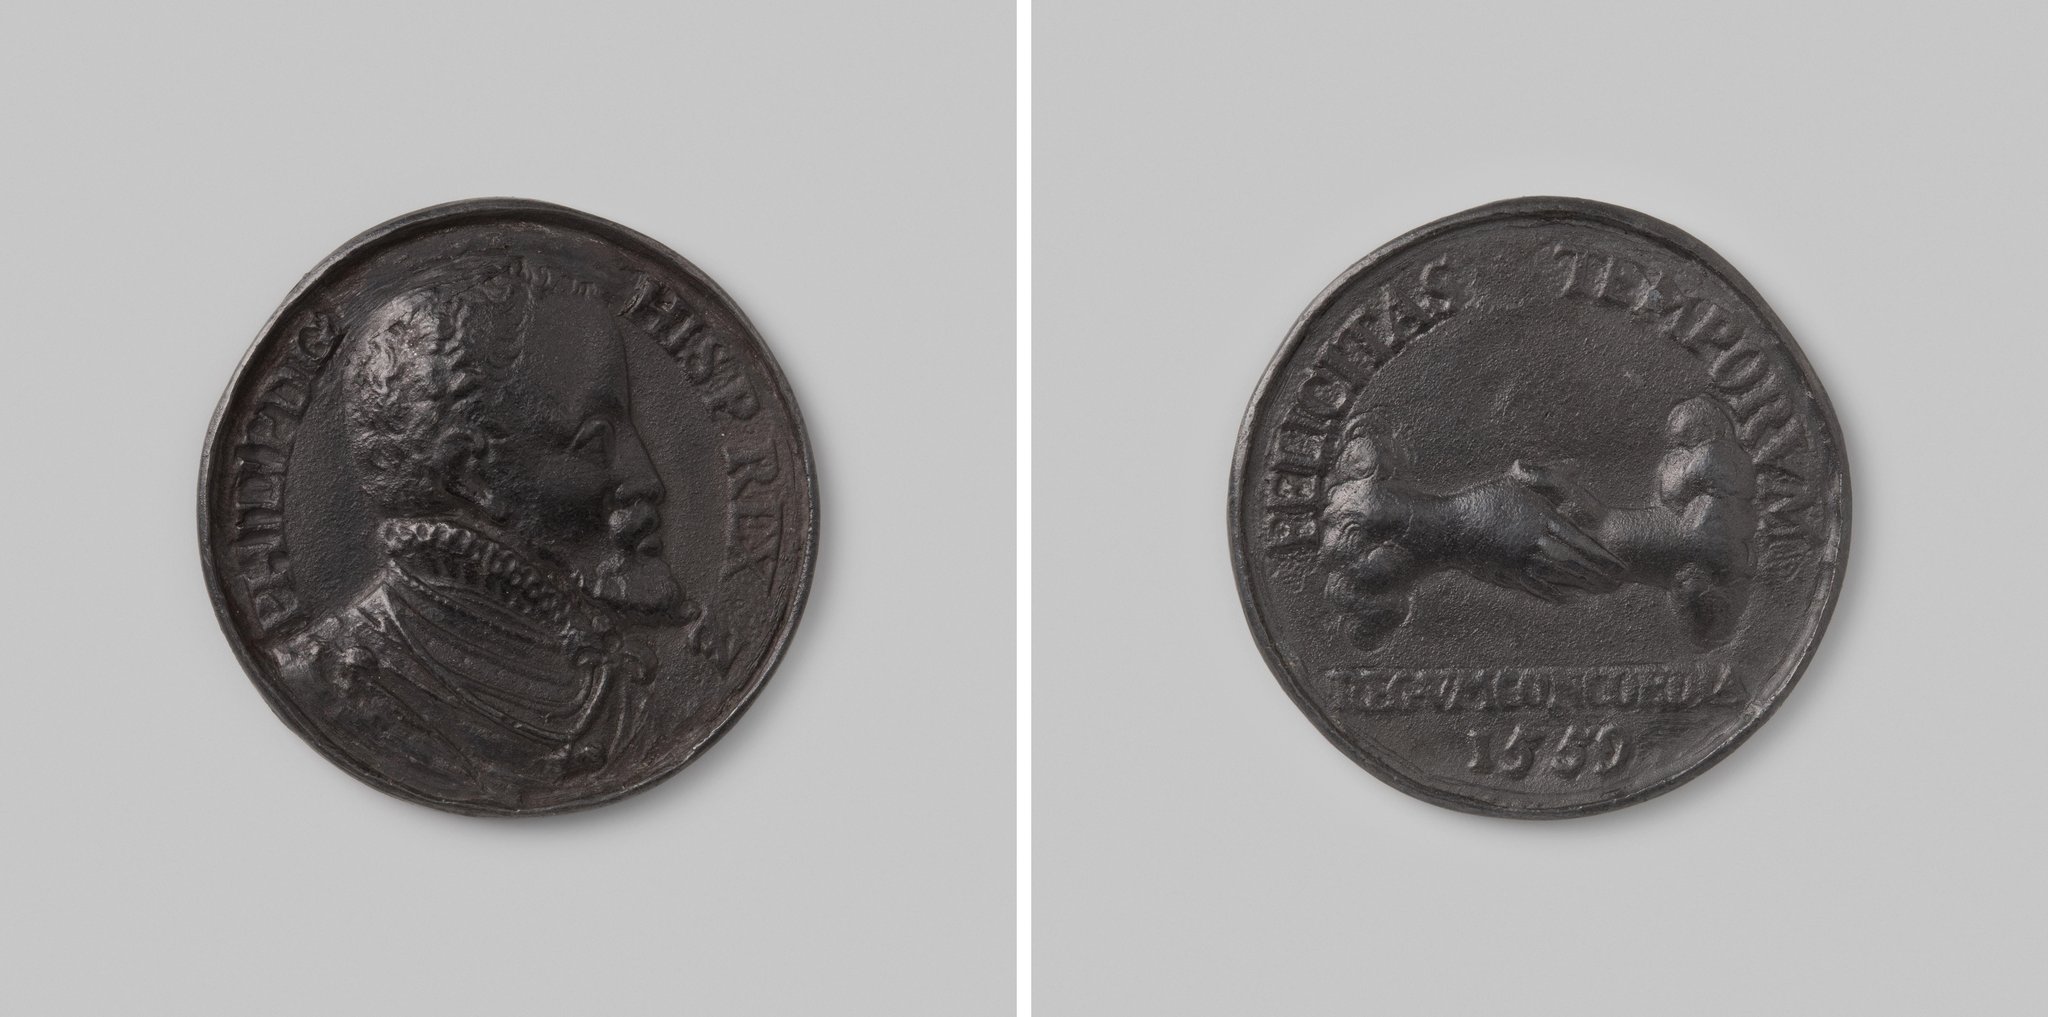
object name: history medal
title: Vrede van Cateau-Cambrésis tussen Spanje en Fankrijk 1559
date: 1559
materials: tin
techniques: casting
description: Tinnen penning, op de voorzijde het portret van Philips II naar rechts met omschrift, op de keerzijde een handdruk met omschrift